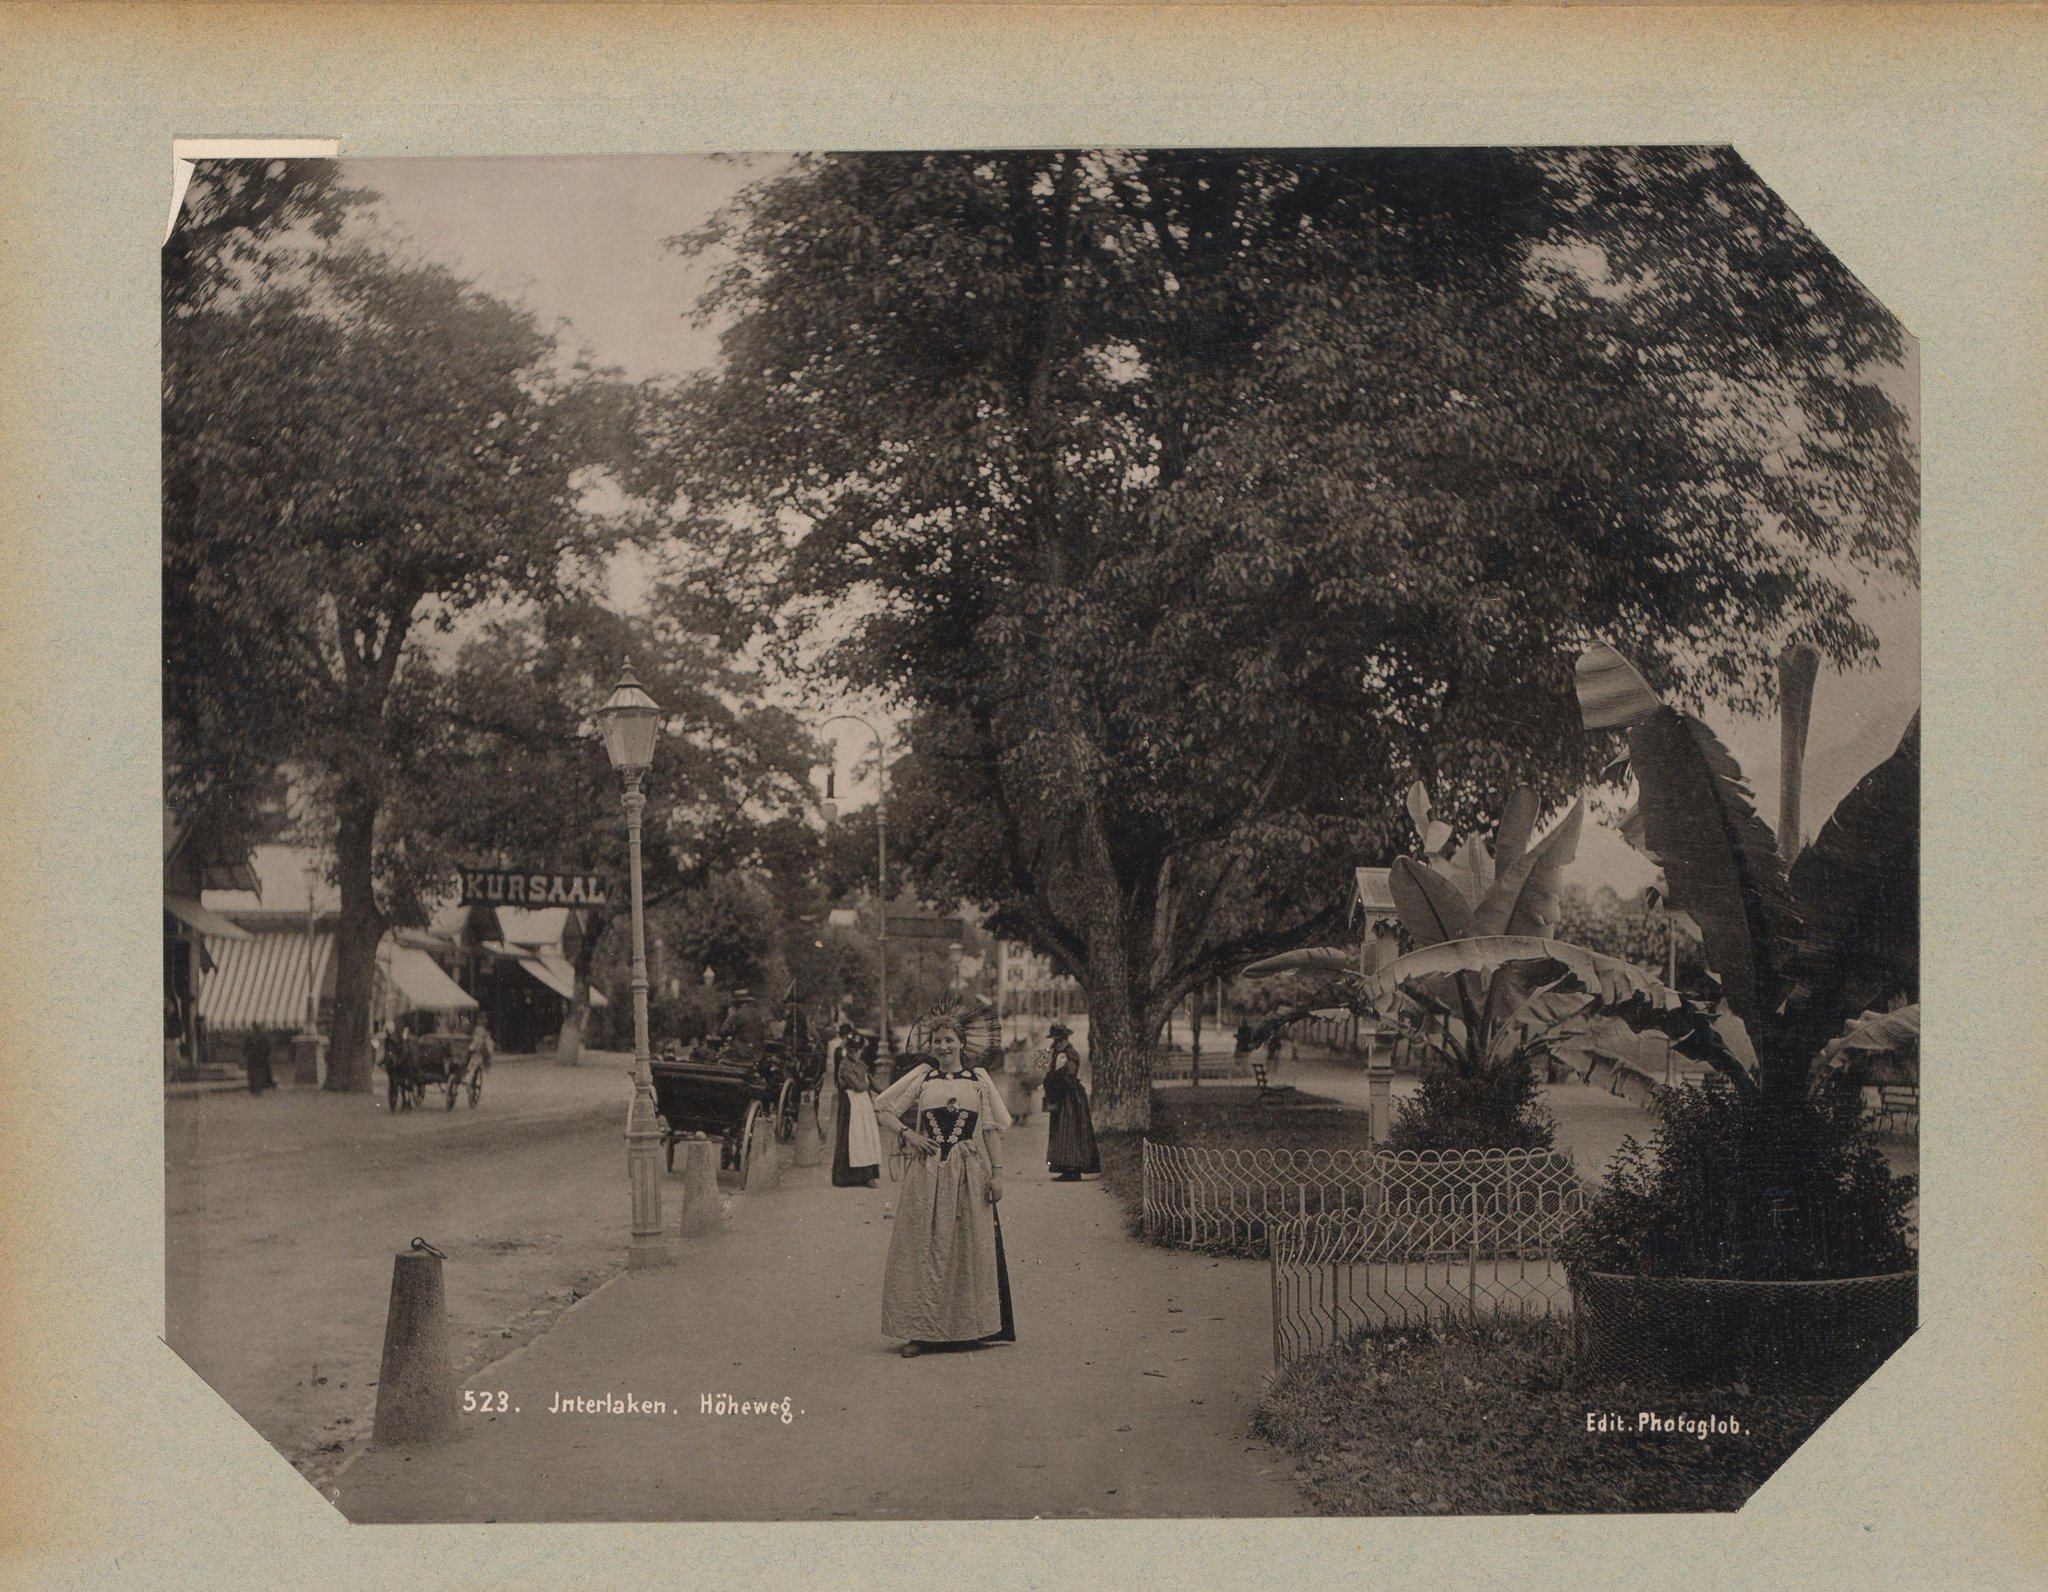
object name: album leaf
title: Straatgezicht met een vrouw in klederdracht op de Höhenweg in Interlaken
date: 1880-1910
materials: paper, ink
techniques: photograph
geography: interlaken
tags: folk costume, regional costume, street (+ city(-scape) with figures, staffage)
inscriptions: number: ‘523’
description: Onderdeel van Reisalbum met bezienswaardigheden in Engeland, Zwitserland, Frankrijk en Duitsland.